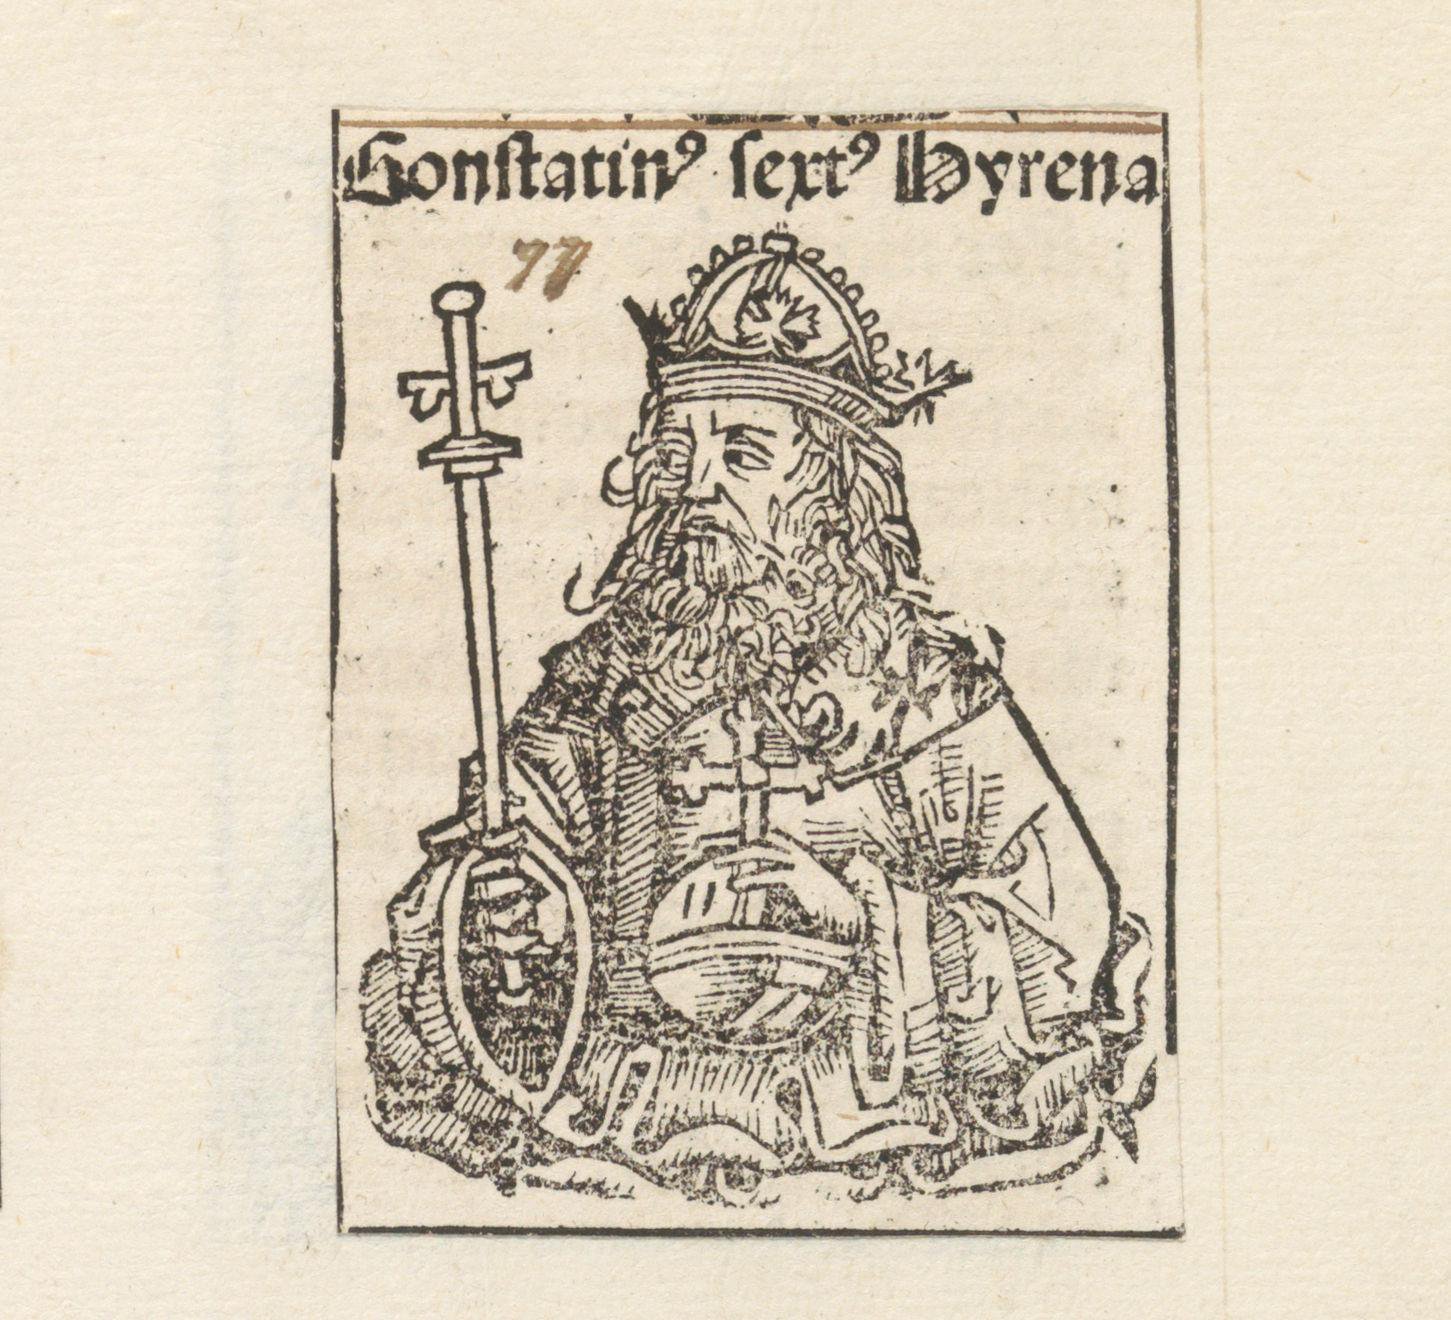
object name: book illustration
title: Liber Chronicarum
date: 1493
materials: paper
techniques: letterpress printing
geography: nuremberg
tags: emperor, king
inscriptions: inscription: ‘77’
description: Een bloemkelk met een koning. Hij heeft een rijksappel en scepter in zijn handen. De voorstelling is onderdeel van de opeenvolging keizers in de Liber Chronicarum. De tekst identificeert de man als keizer Constantijn VI. De prent maakt deel uit van een album.